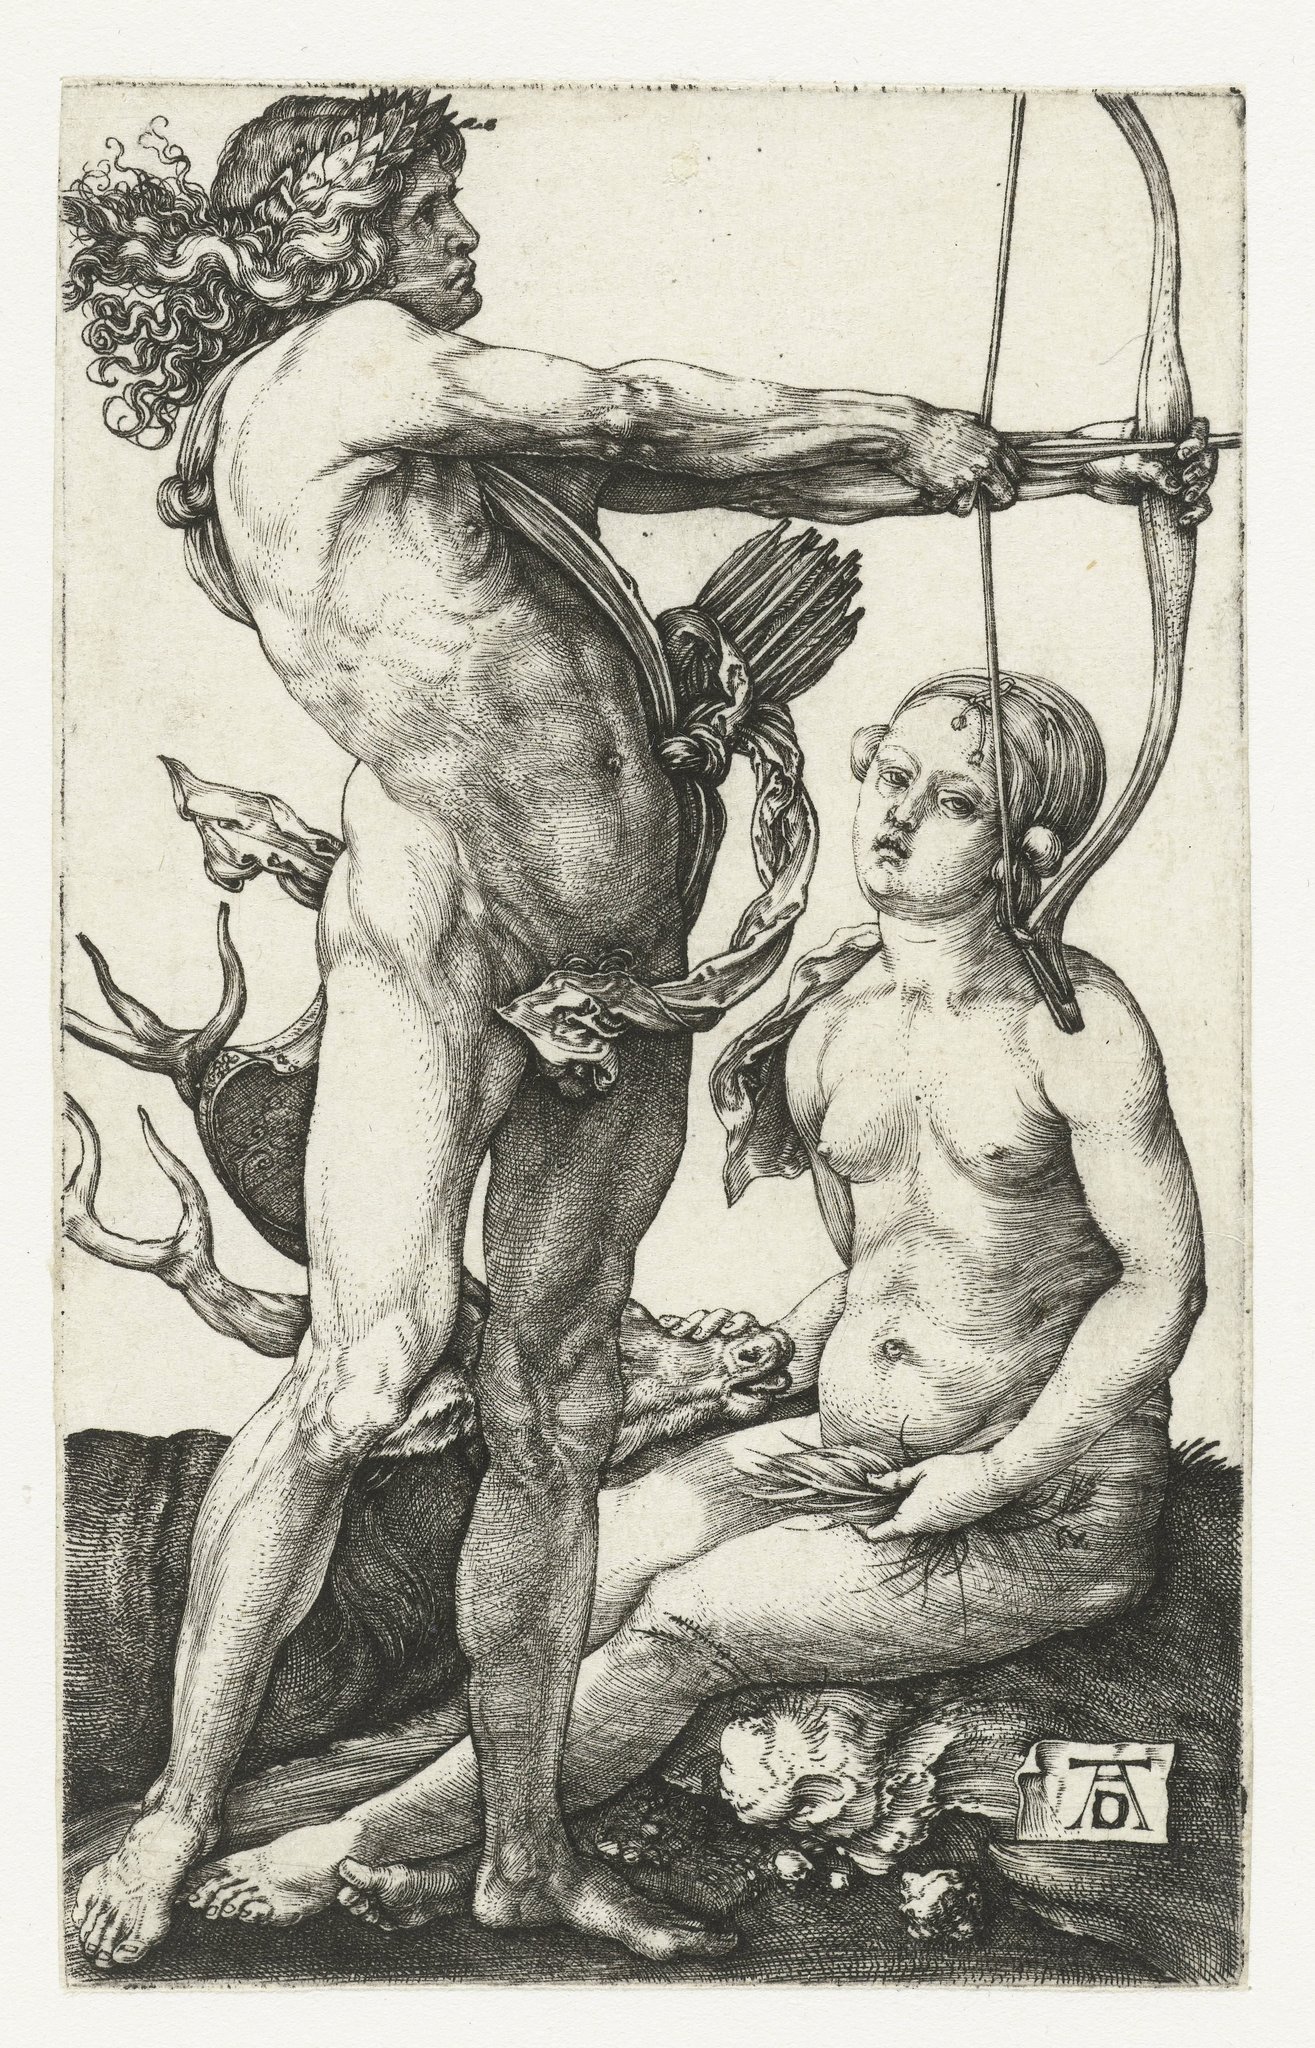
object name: print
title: Apollo en Diana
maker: albrecht dürer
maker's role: draughtsman, painter, print maker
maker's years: 1471-1528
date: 1501-1506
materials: paper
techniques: engraving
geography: nuremberg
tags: (story of) diana (artemis), (story of) apollo (phoebus)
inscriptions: collector's mark: Lugt 2228a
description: Apollo spant zijn boog. Diana zit naast hem met een hert.